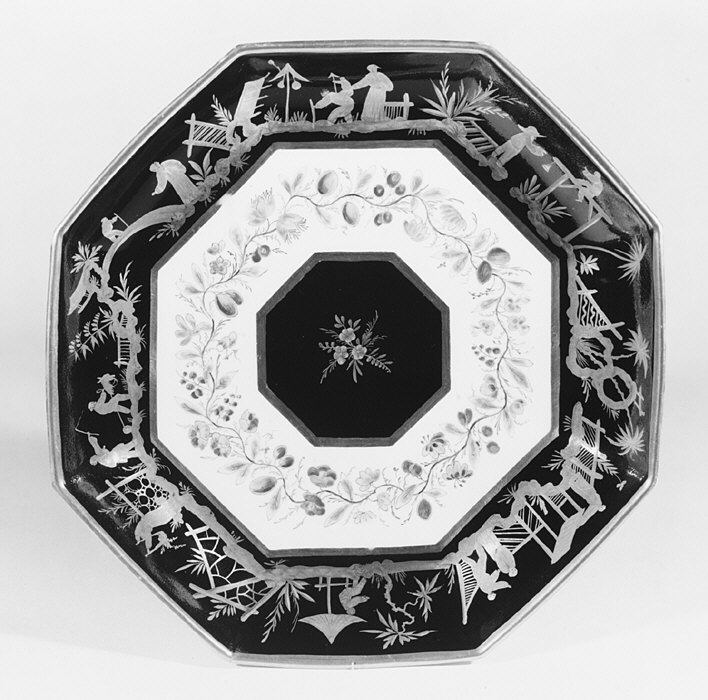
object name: dish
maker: sèvres manufactory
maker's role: manufactory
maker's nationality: french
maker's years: 1740-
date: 1804-1813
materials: hard paste porcelain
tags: chinoiserie,men,flowers